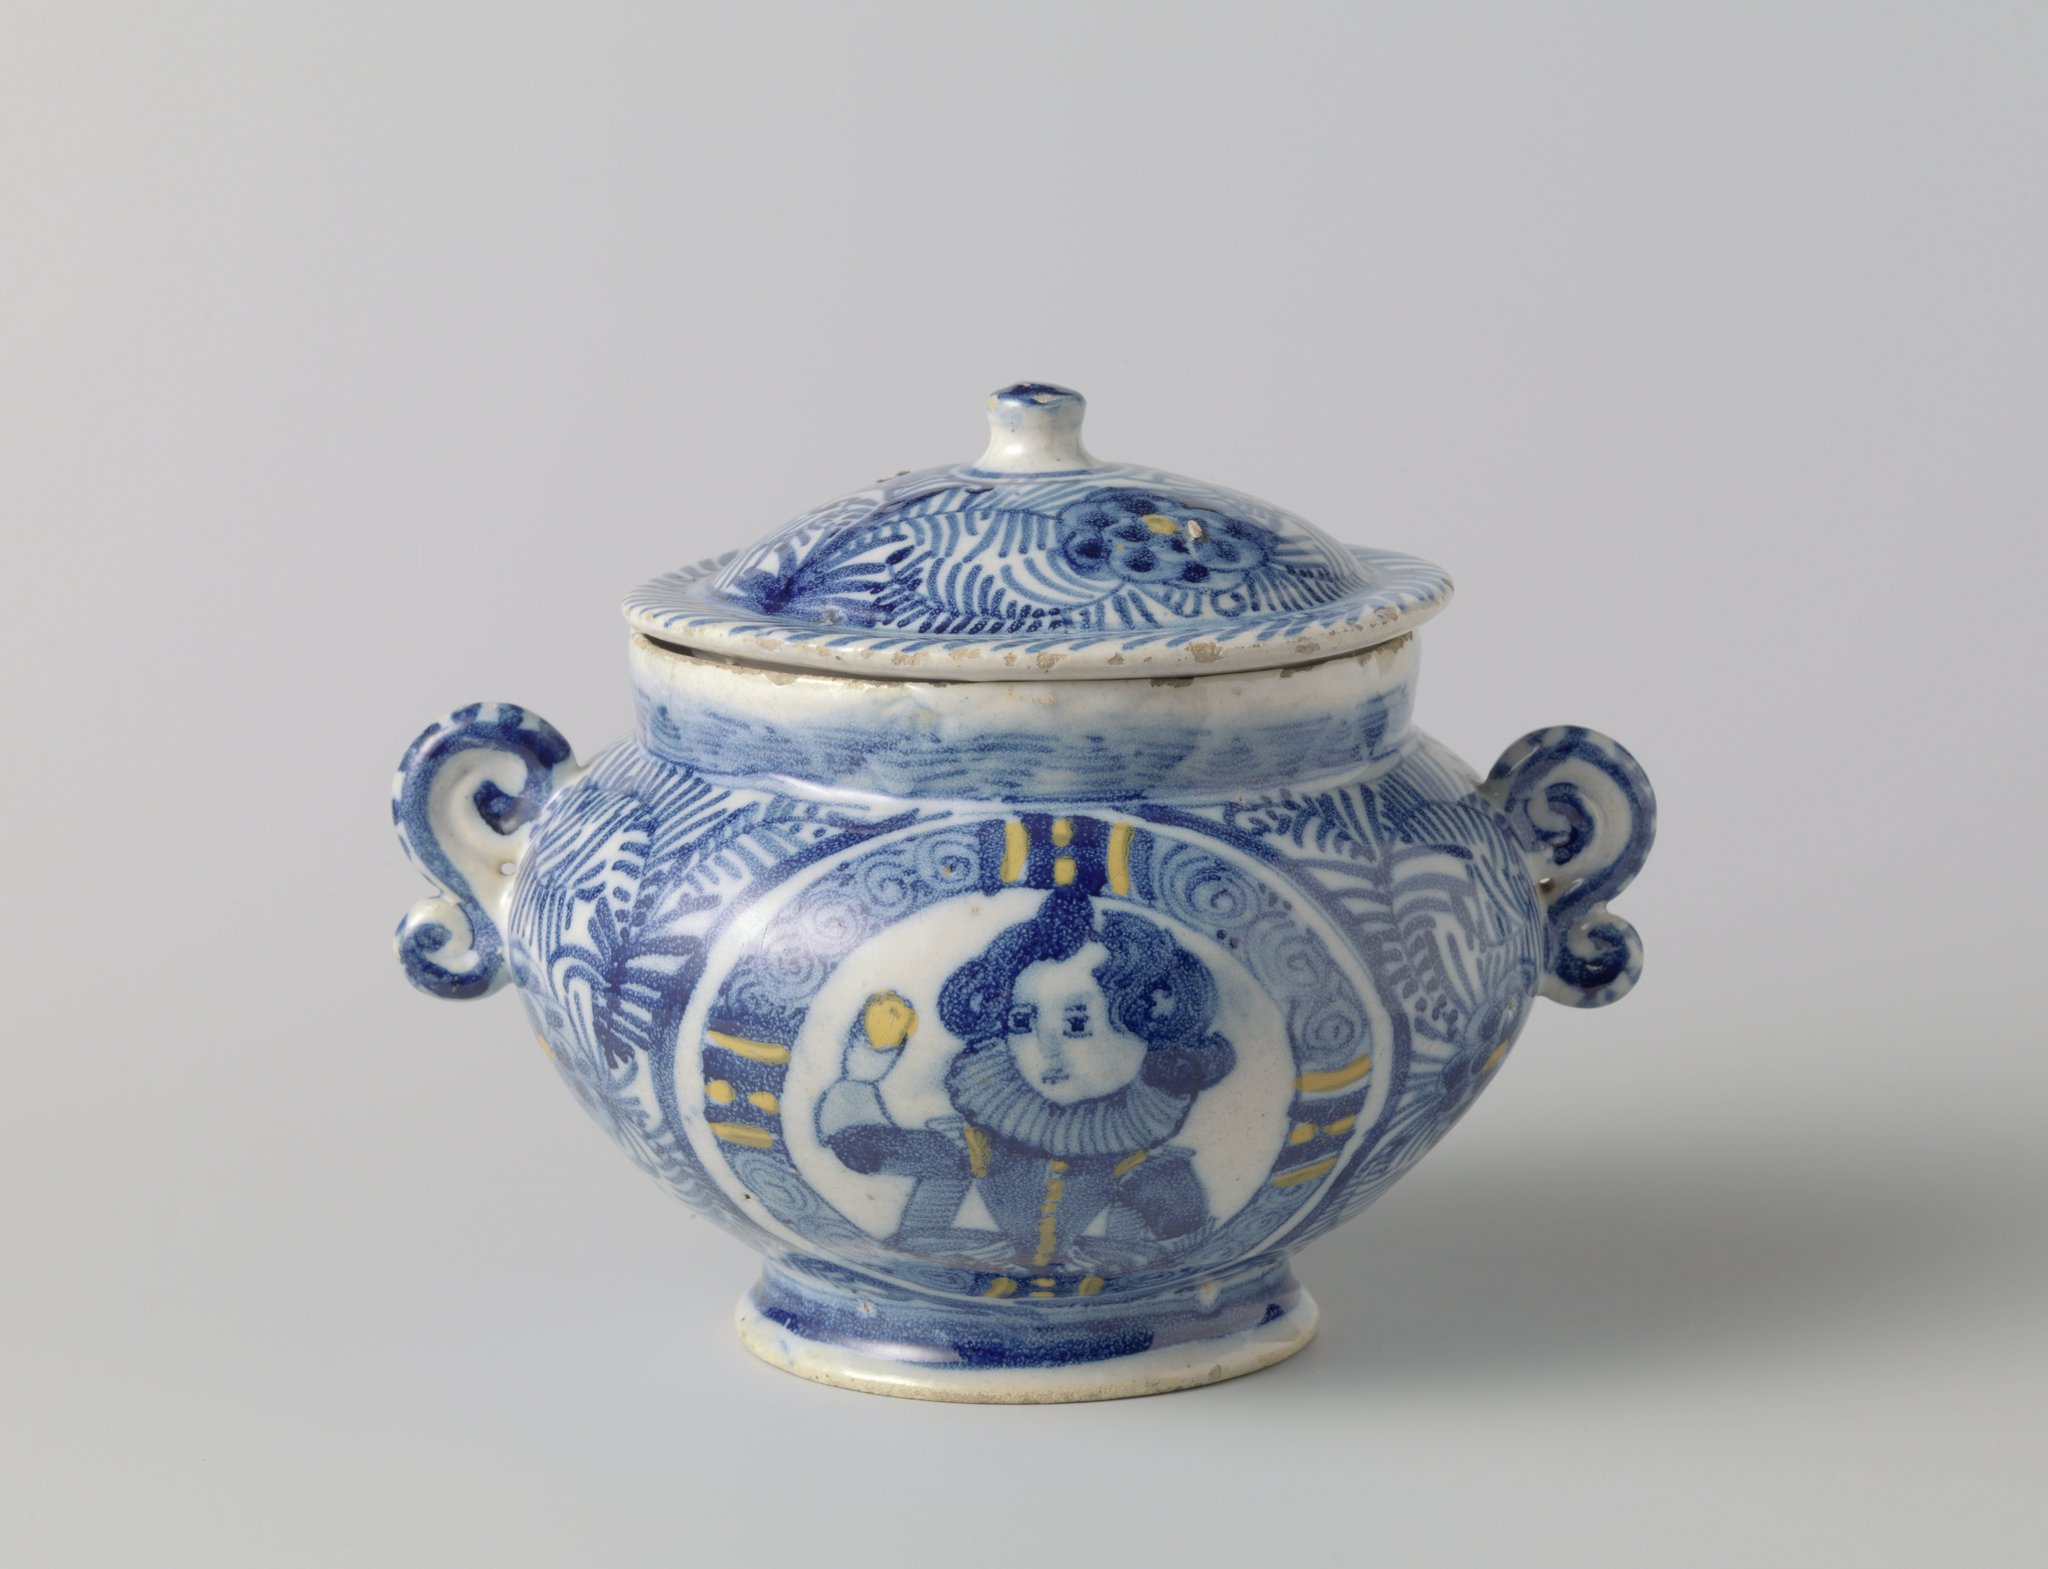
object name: vessel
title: Deksel van pot, beschilderd met takken, bladeren en bloemen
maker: Anonymous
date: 1625-1650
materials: earthenware, glaze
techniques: painted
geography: portugal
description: Rond deksel van blauw en geel beschilderde faience, met een knop. Het deksel hoort op een pot met invnr. BK-1958-4-A. Het deksel is licht gewelfd en heeft een uitstaande rand. Het deksel is beschilderd met takken met streperige bladeren en grote bloemen.